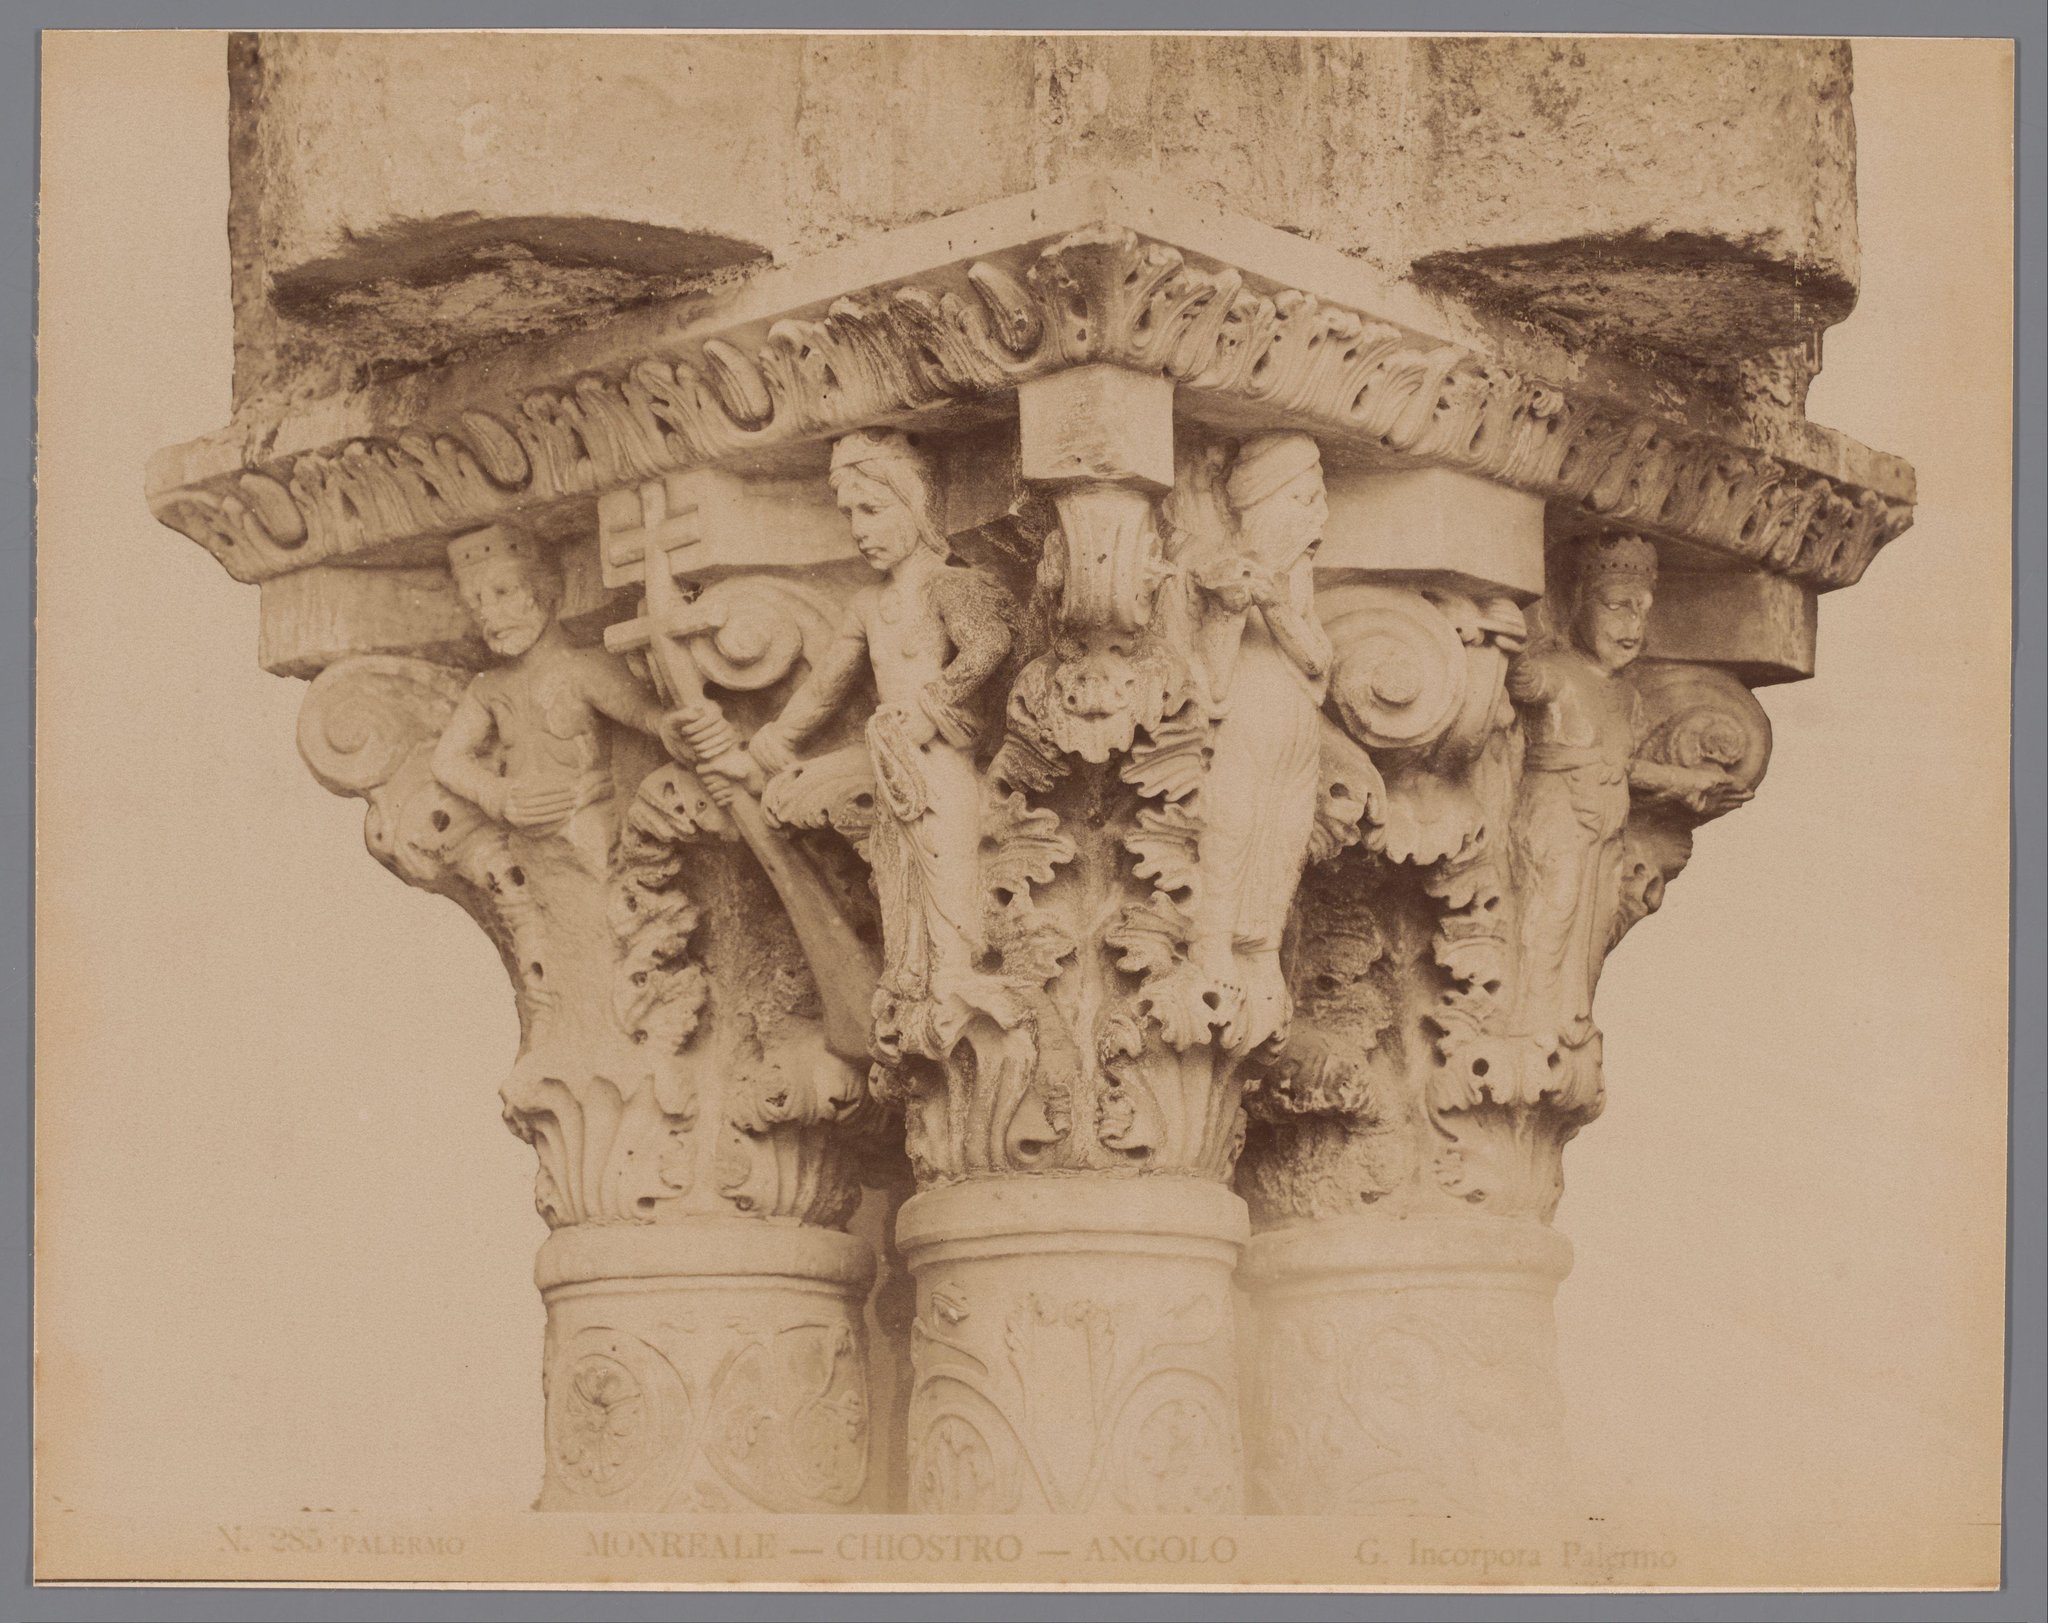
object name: photograph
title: Detailopname van een kapiteel in de kloostergang van de dom van Monreale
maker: giuseppe incorpora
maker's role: fotograaf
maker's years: 1834-1914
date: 1856-1914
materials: cardboard, paper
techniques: albumen print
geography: monreale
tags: abbey, monastery, convent ~ roman catholic church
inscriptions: number: ‘N. 283’